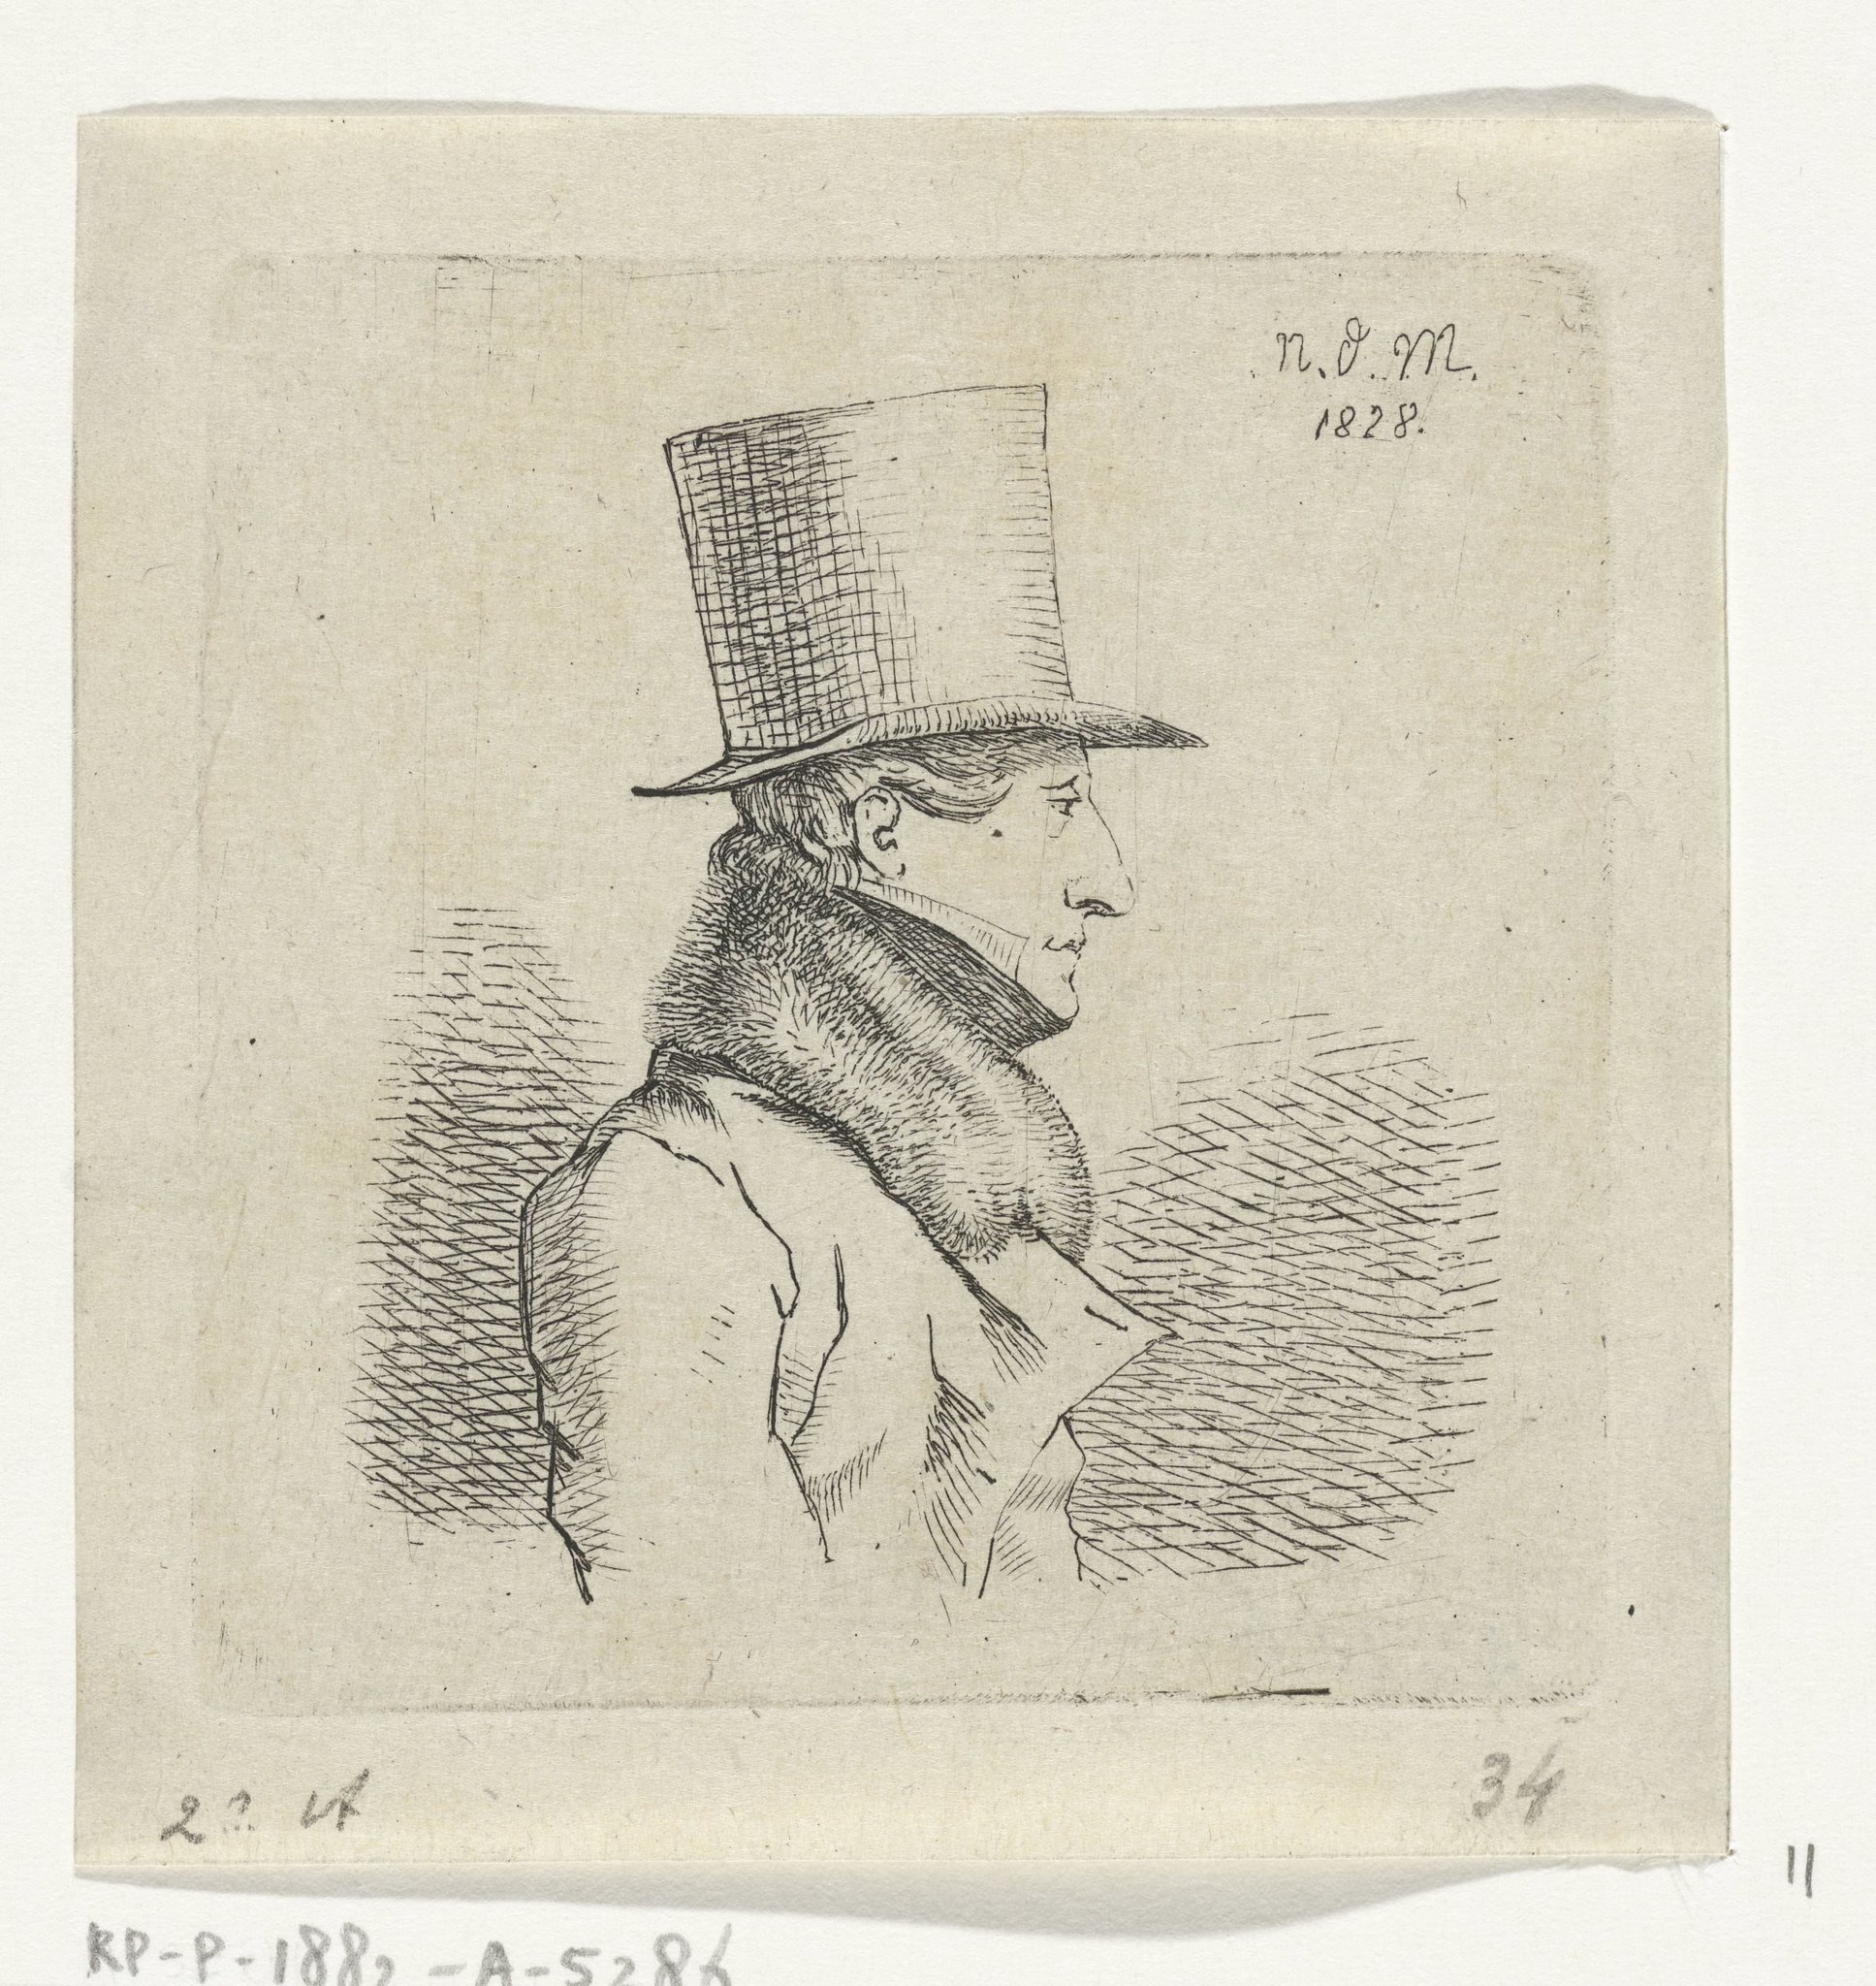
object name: print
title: Man met hoge hoed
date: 1828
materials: paper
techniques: etching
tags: head-gear: hat (+ men's clothes)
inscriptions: collector's mark: Lugt 2227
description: Een man met hoge hoed en een bontkraag, in profiel naar links.